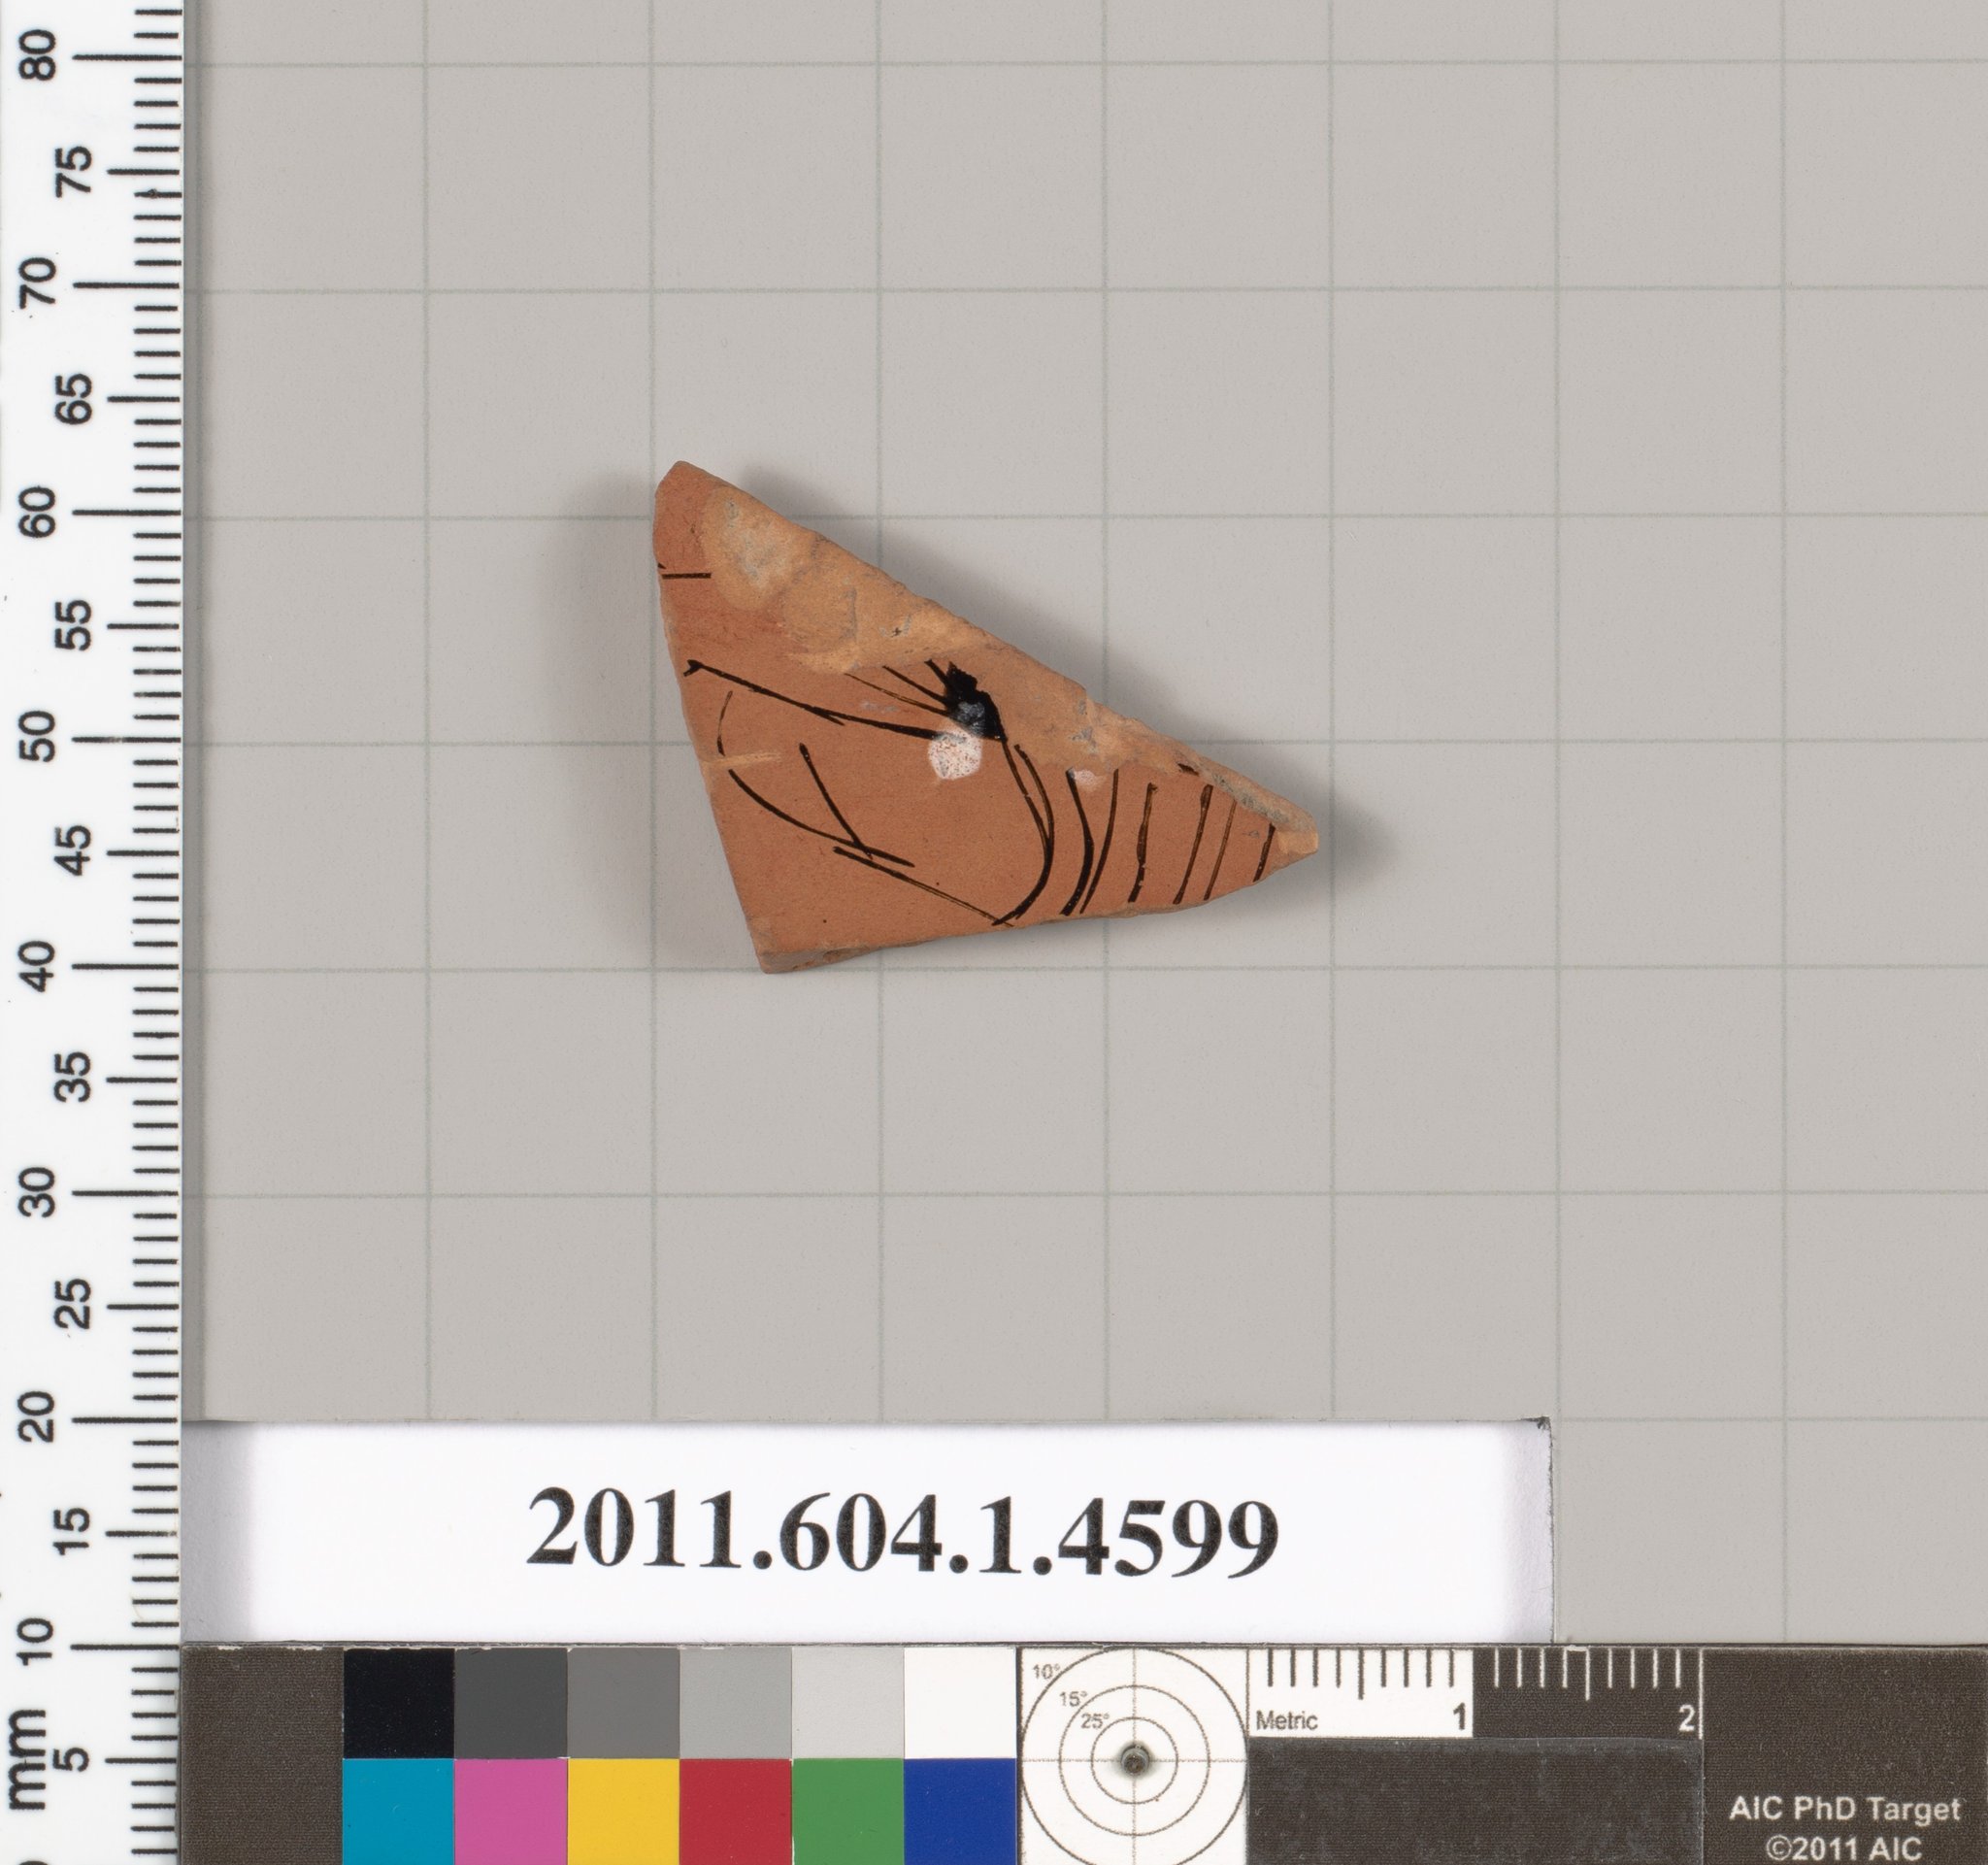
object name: kylix fragment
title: Terracotta fragment of a kylix (drinking cup)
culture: greek, attic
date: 475-451 BCE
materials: terracotta